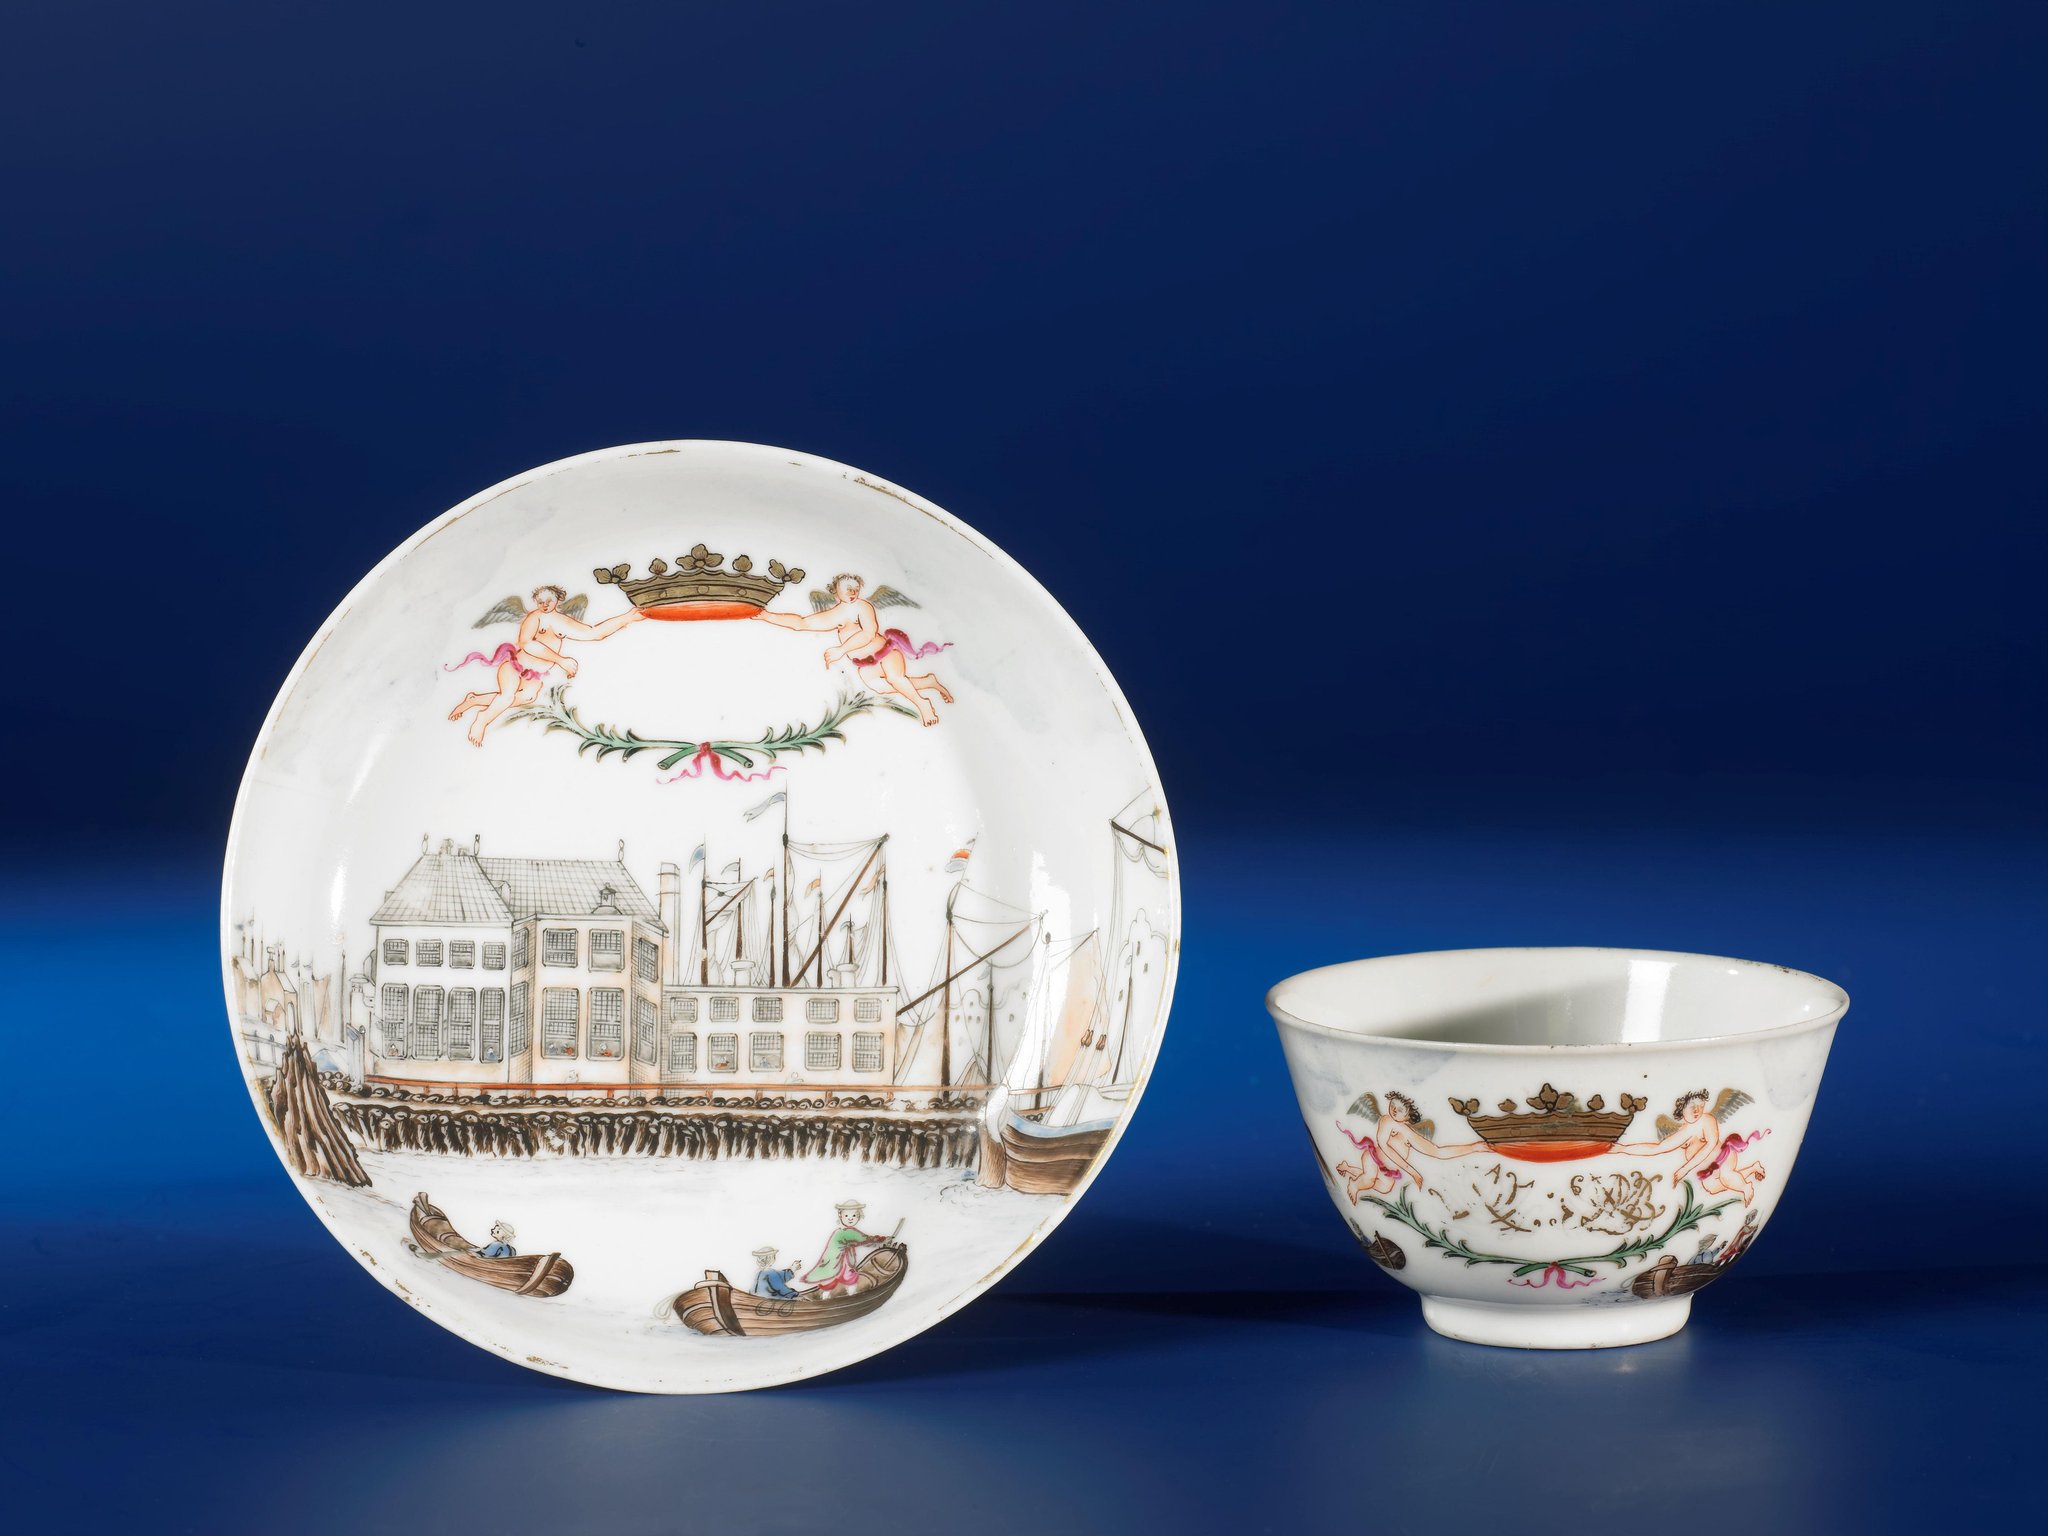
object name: cup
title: Bell-shaped cup with a port scene of Amsterdam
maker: Anonymous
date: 1765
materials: glaze, gold, paint, porcelain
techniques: firing, gilding, turning, vitrification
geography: china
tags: amsterdam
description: Kop en schotel op een voetring, gedecoreerd in emailkleuren met een voorstelling van de Nieuwe Stadsherberg aan het IJ te Amsterdam. Op de schotel is boven de herberg een cartouche weergegeven, aan weerszijden twee engeltjes die een kroon vasthouden. De Stadsherberg aan het IJ in Amsterdam werd in 1662 gebouwd, en vernietigd in 1872. De Stadsherberg stond op de plaats waar zich thans het Centraal Station bevindt. De prent waarnaar dit tafereel is geschilderd is tot op heden niet gevonden. Een prent van Michael Zeeman wordt echter wel vaak in verband gebracht met de voorstelling op het porselein. De prent laat de Stadsherberg zien met een tweede verdieping op de rechterzijde van het gebouw. Op het porselein is hier maar één verdieping te zien.